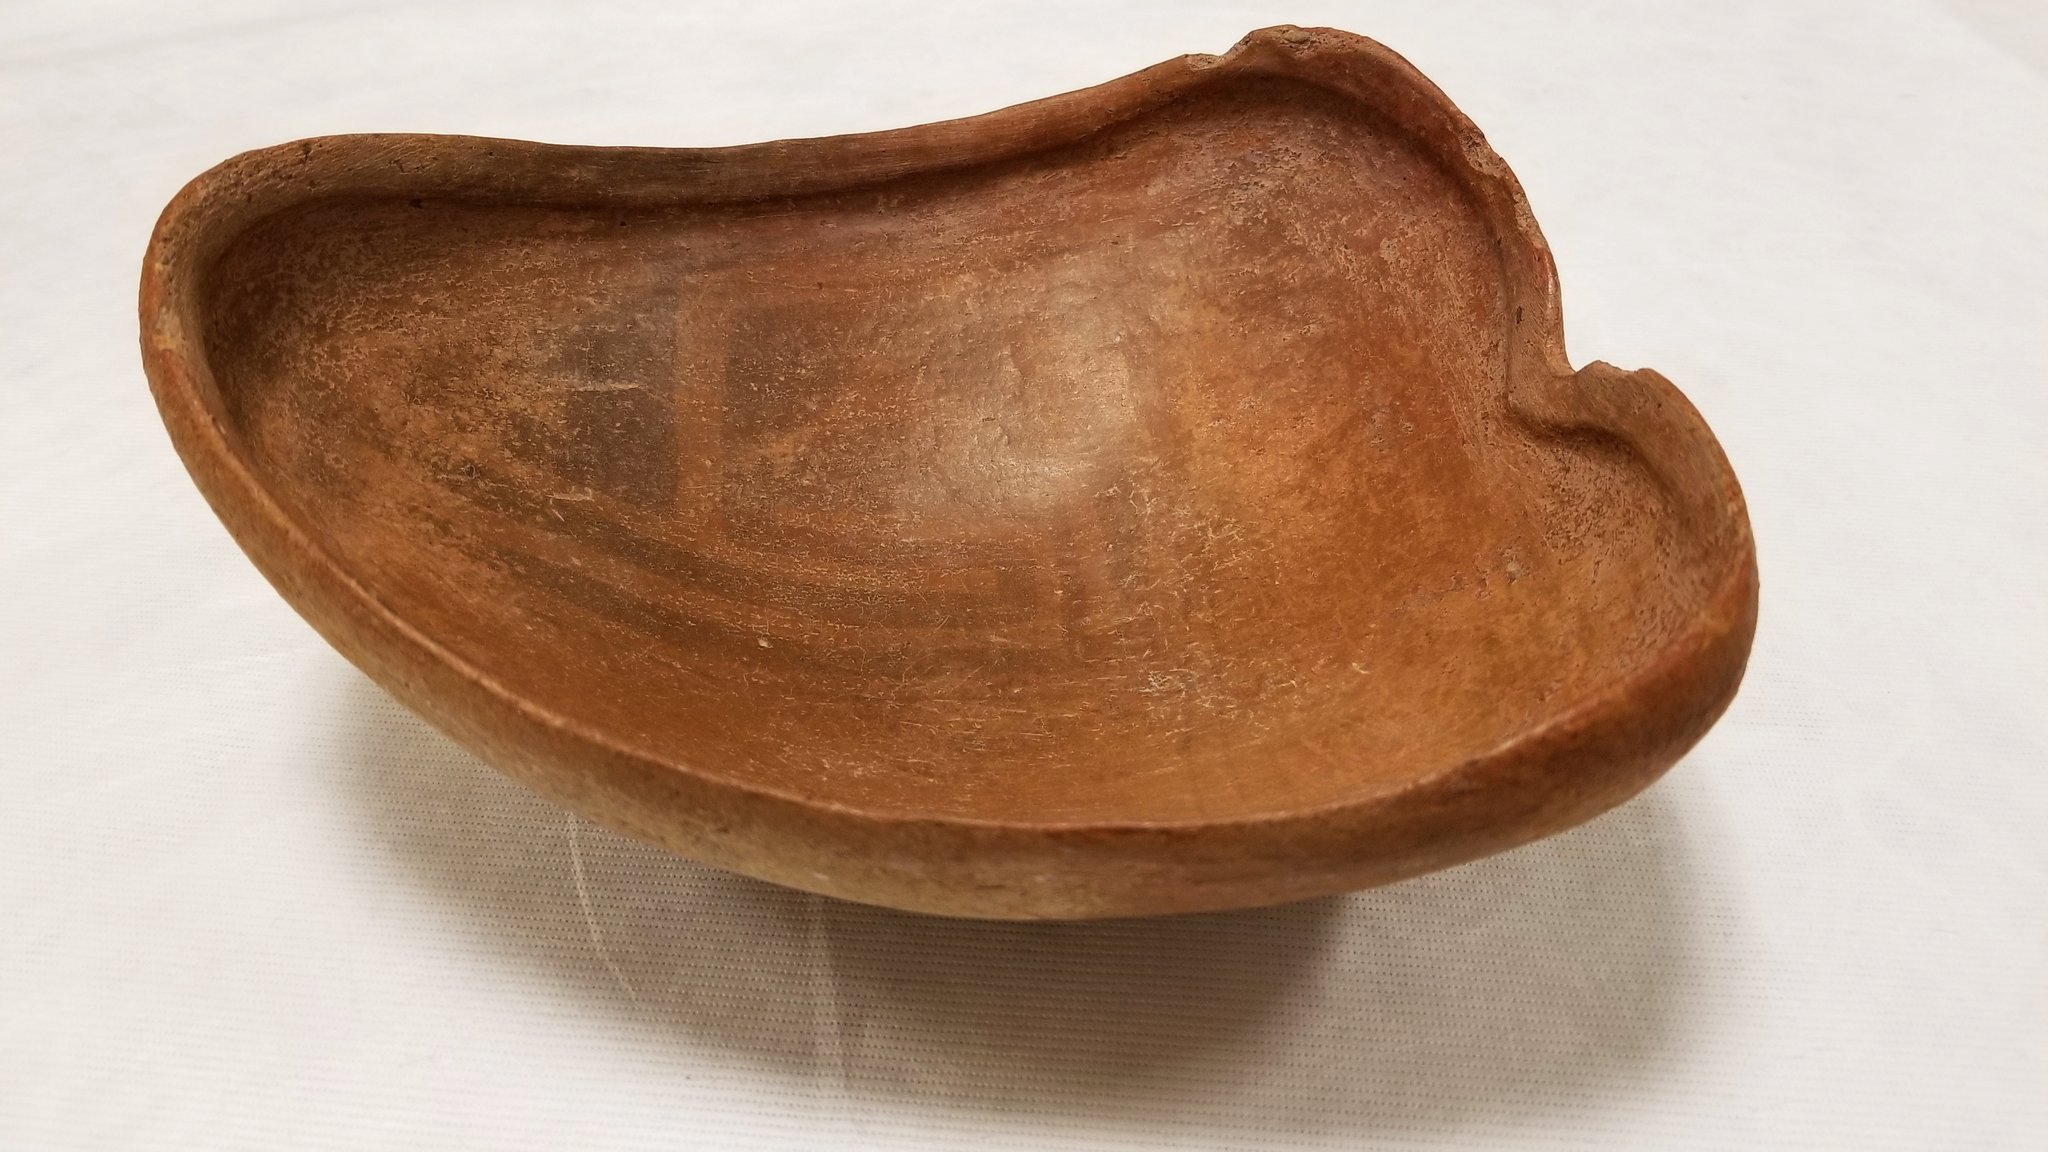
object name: bowl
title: Bowl with Resist Design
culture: proto-taíno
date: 601-1000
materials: ceramic, pigment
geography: dominican republic